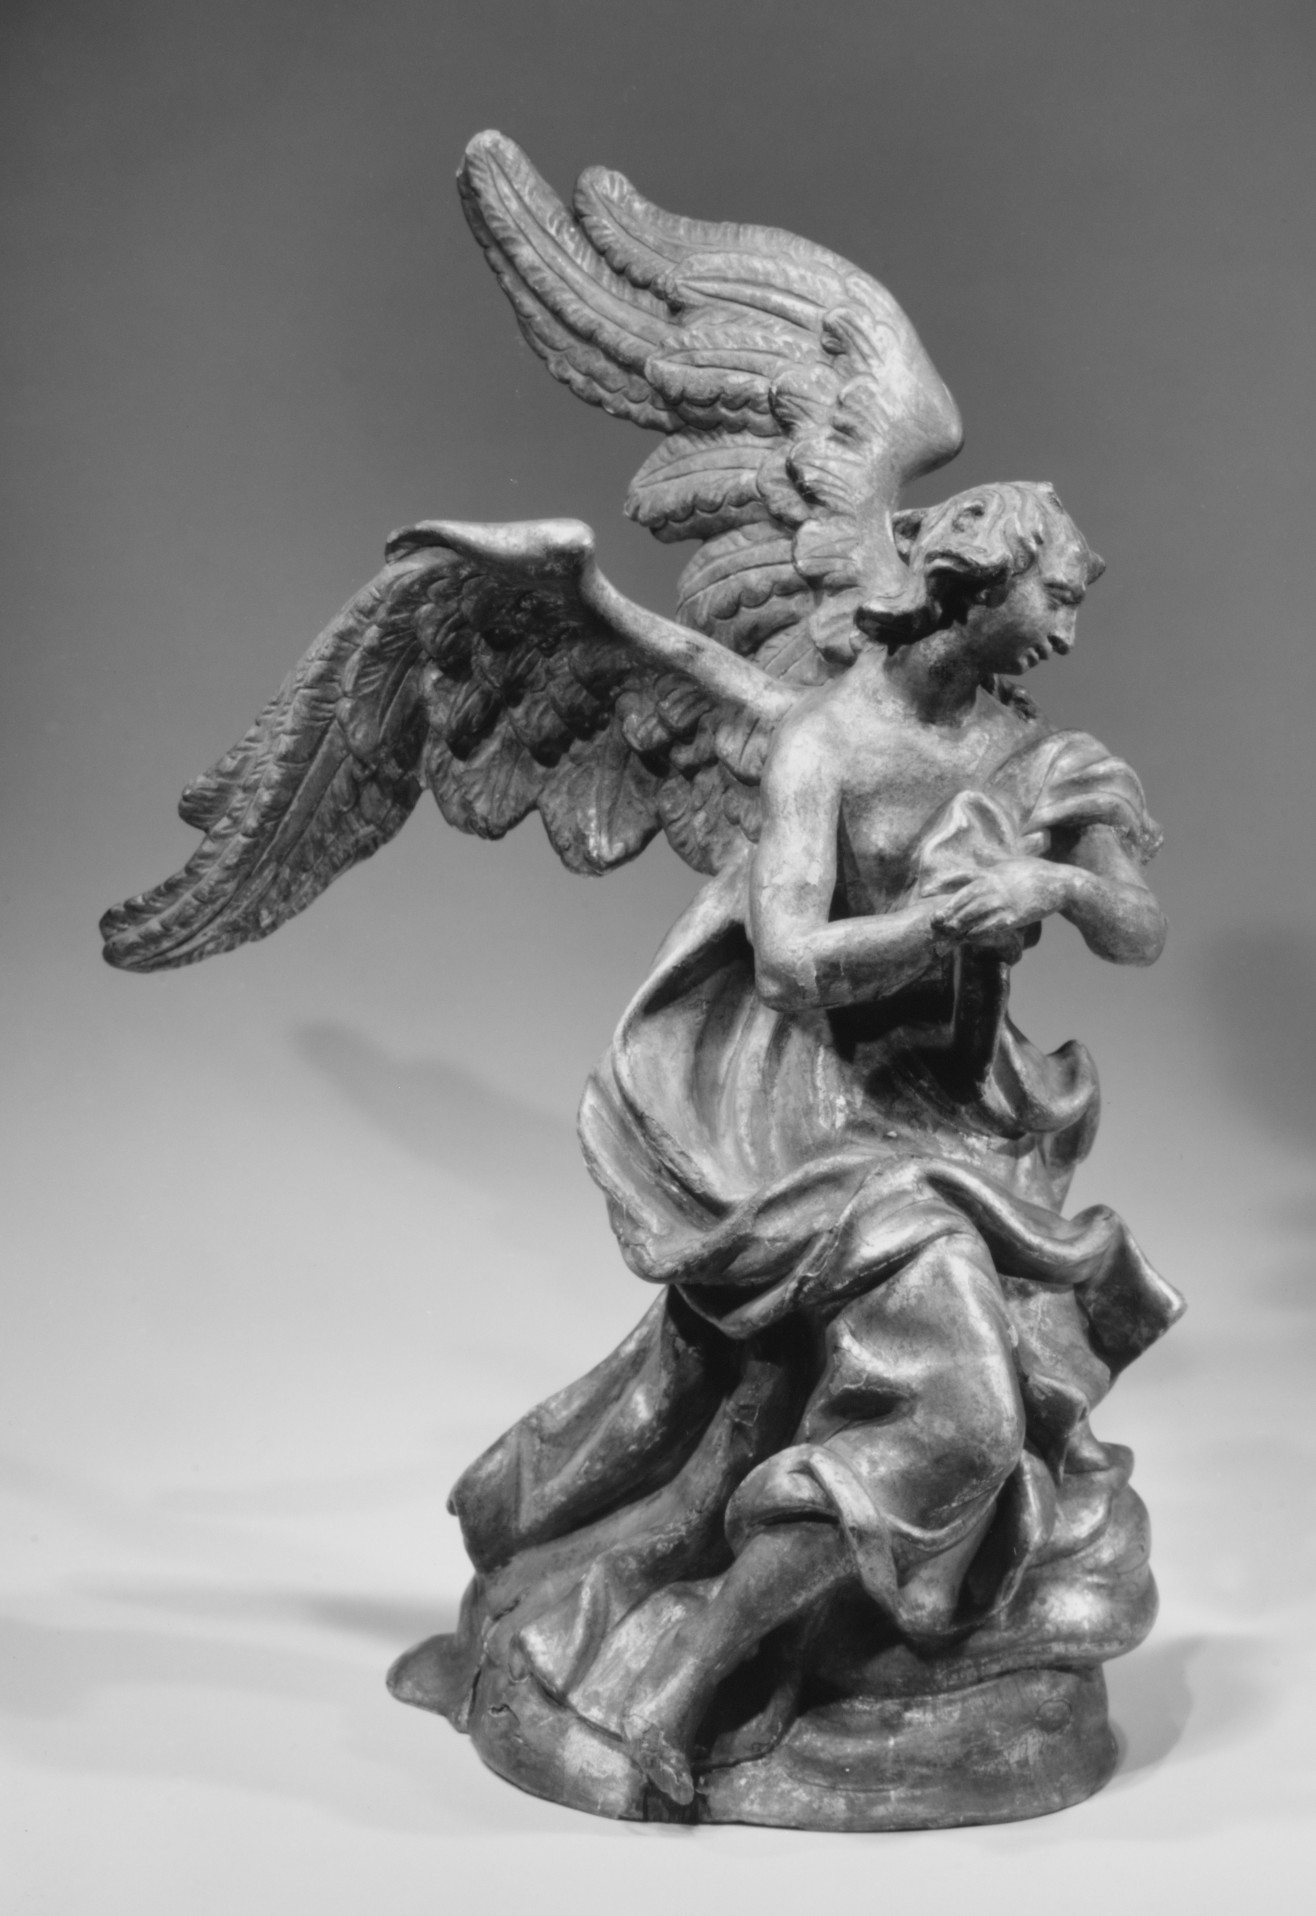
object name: angel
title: Kneeling angel (one of a pair)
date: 1734-1766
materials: gilt, wood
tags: angels